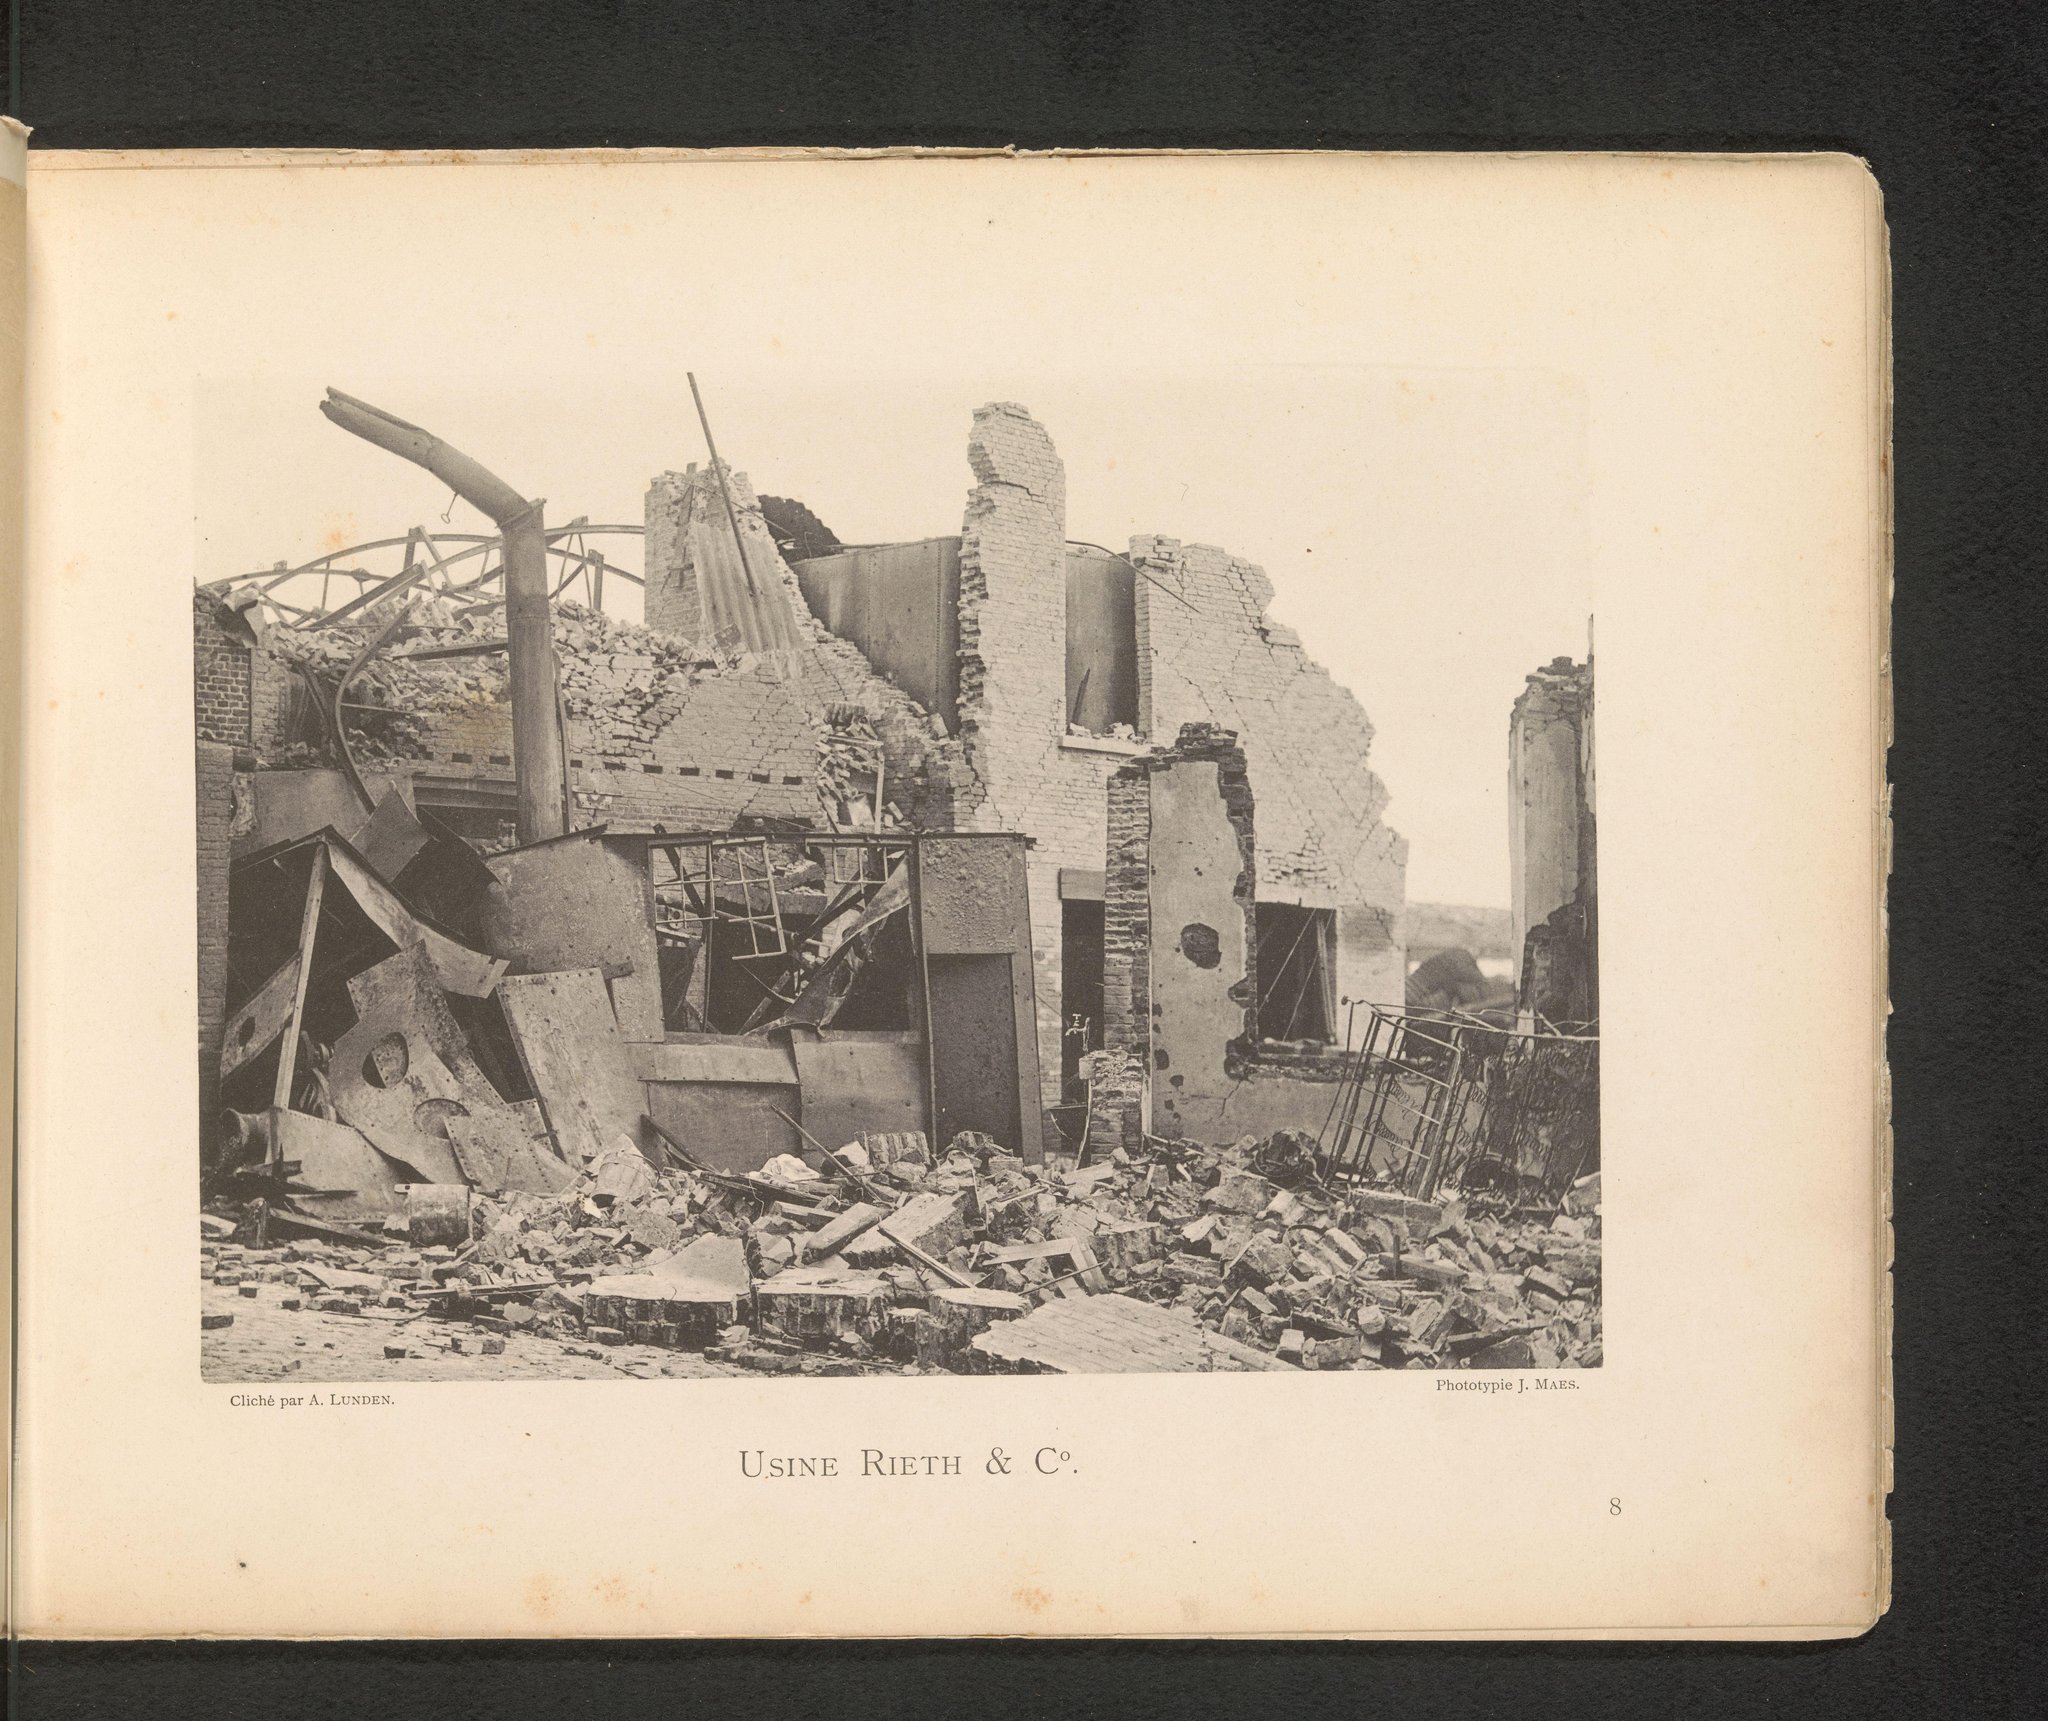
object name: photomechanical print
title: Fabrieksgebouw van Rieth & co dat is verwoest door de ontploffing van een munitiefabriek in Oosterweel bij Antwerpen op 6 september 1889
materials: paper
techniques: photograph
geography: oosterweel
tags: ruin of a building ~ architecture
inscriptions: number: ‘8’